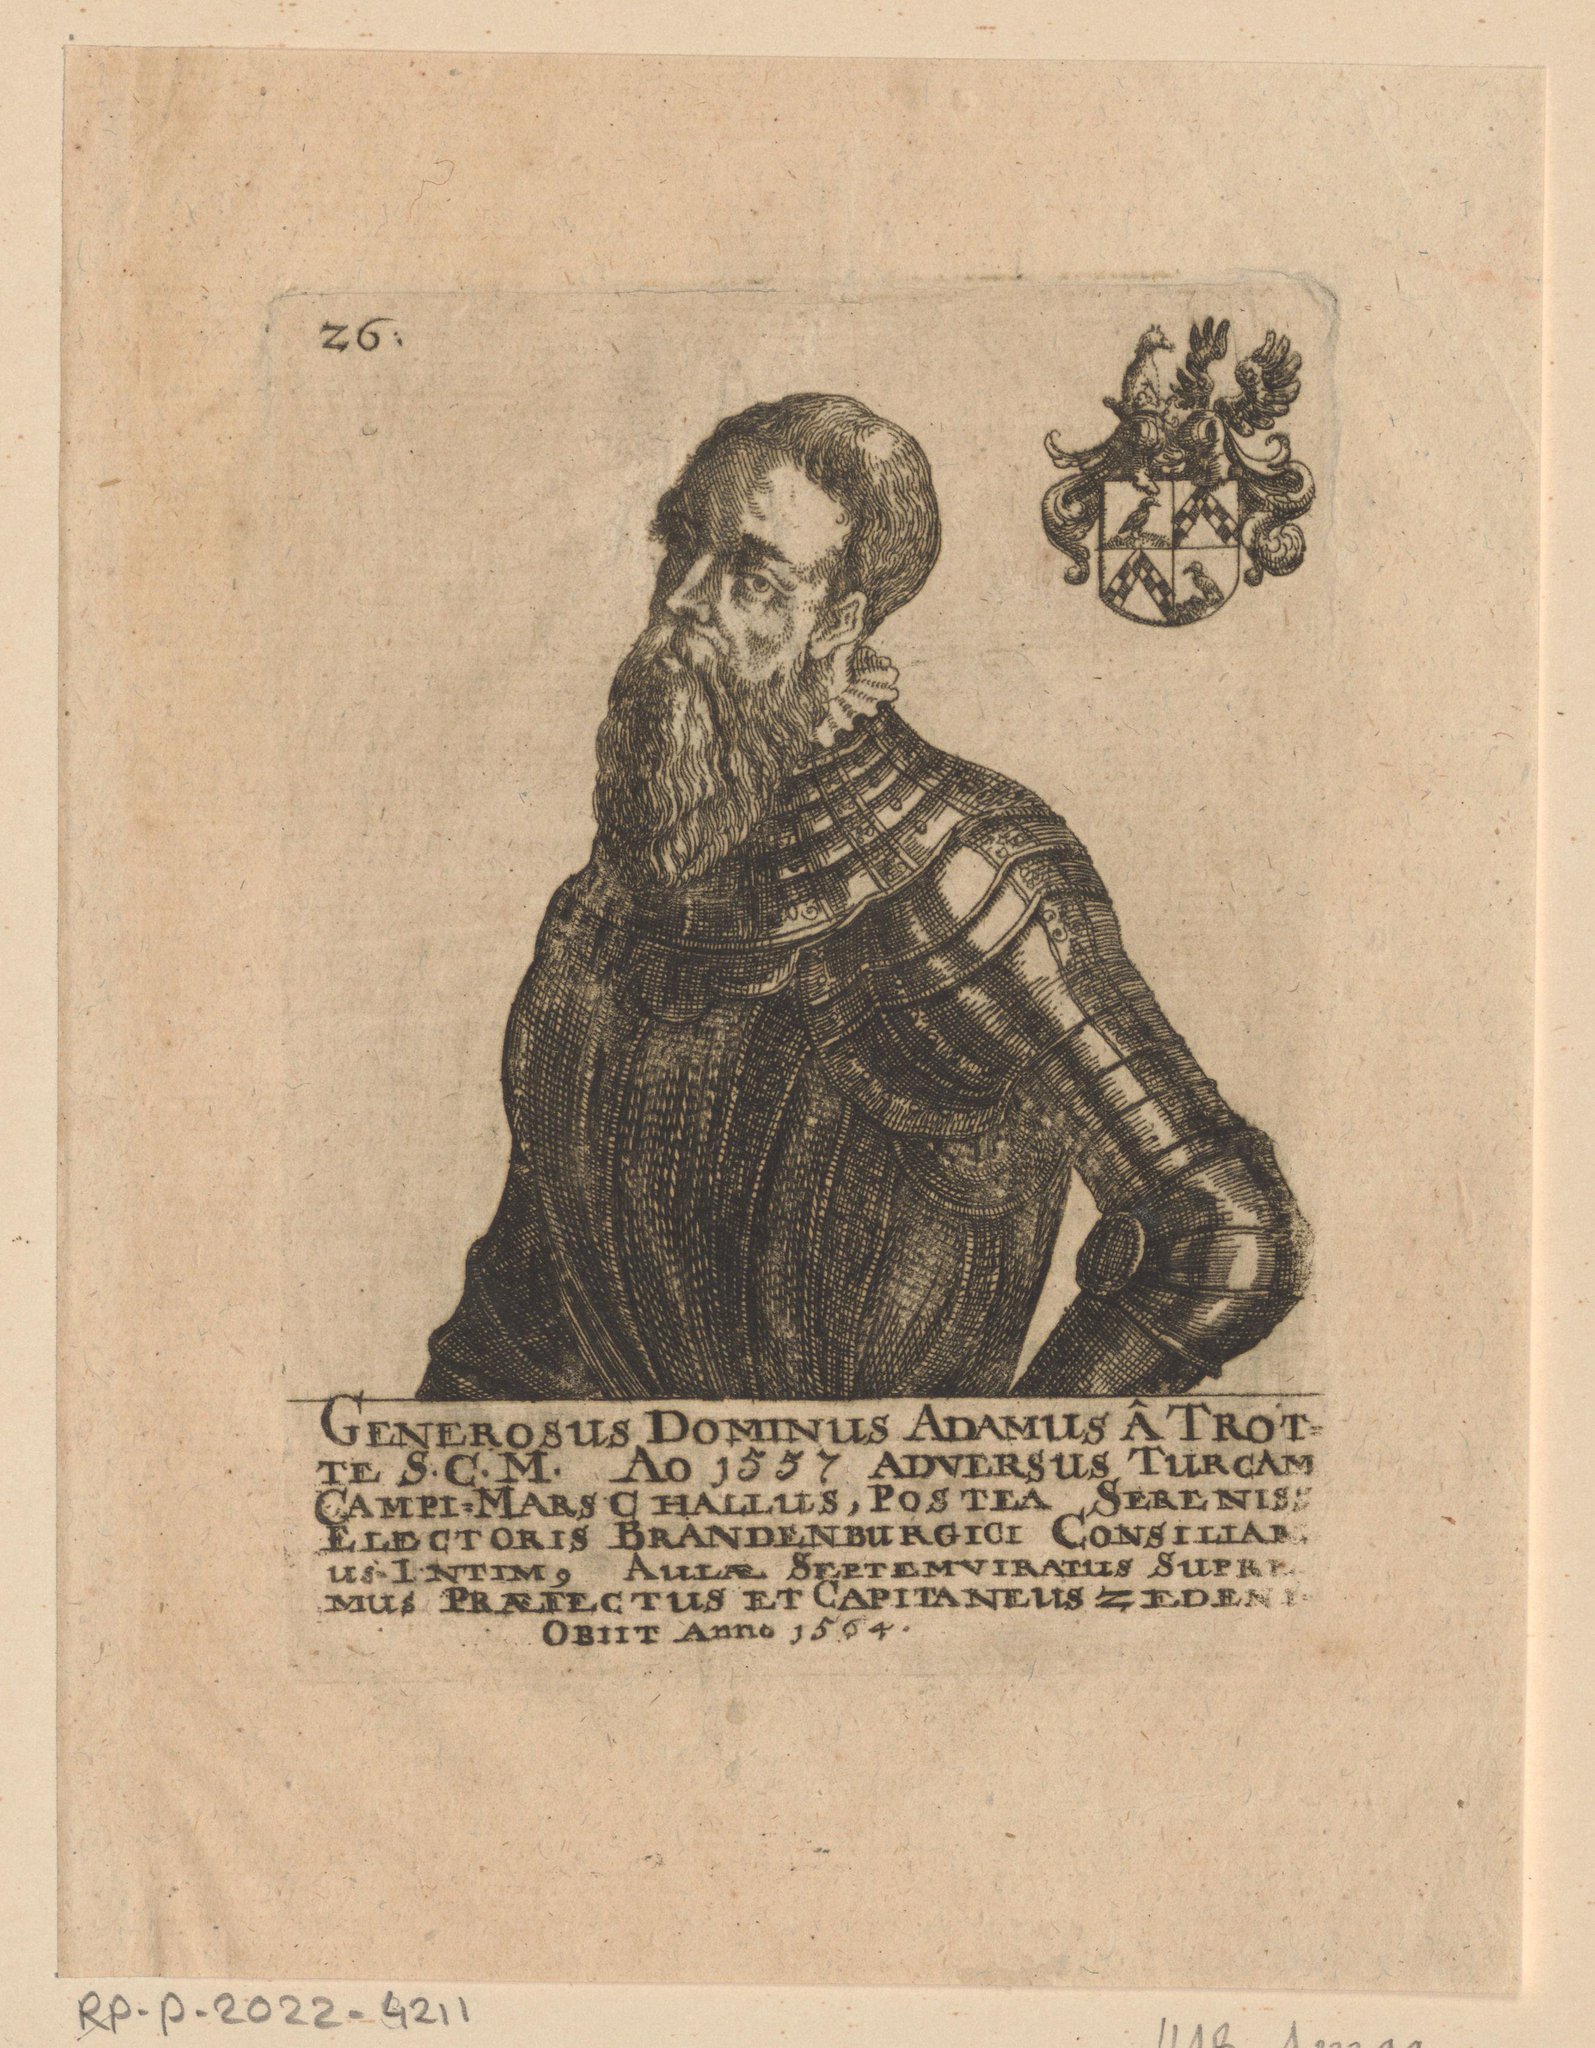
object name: print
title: Portret van Adam von Trott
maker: Anonymous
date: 1671-1751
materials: paper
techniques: etching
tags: commander-in-chief, general, marshal, historical persons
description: De prent is uitgegeven als onderdeel van een serie. Later is de prent mogelijk ook als boekillustratie gebruikt in: Küster, Georg Gottfried. Martin Friedrich Seidels Bilder-Sammlung in welcher hundert, gröstentheils in der Mark Brandenburg (…). Berlijn: Buchladen bey der Real-Schule, 1751. Het is onduidelijk tot welke uitgave de huidige prent behoort.